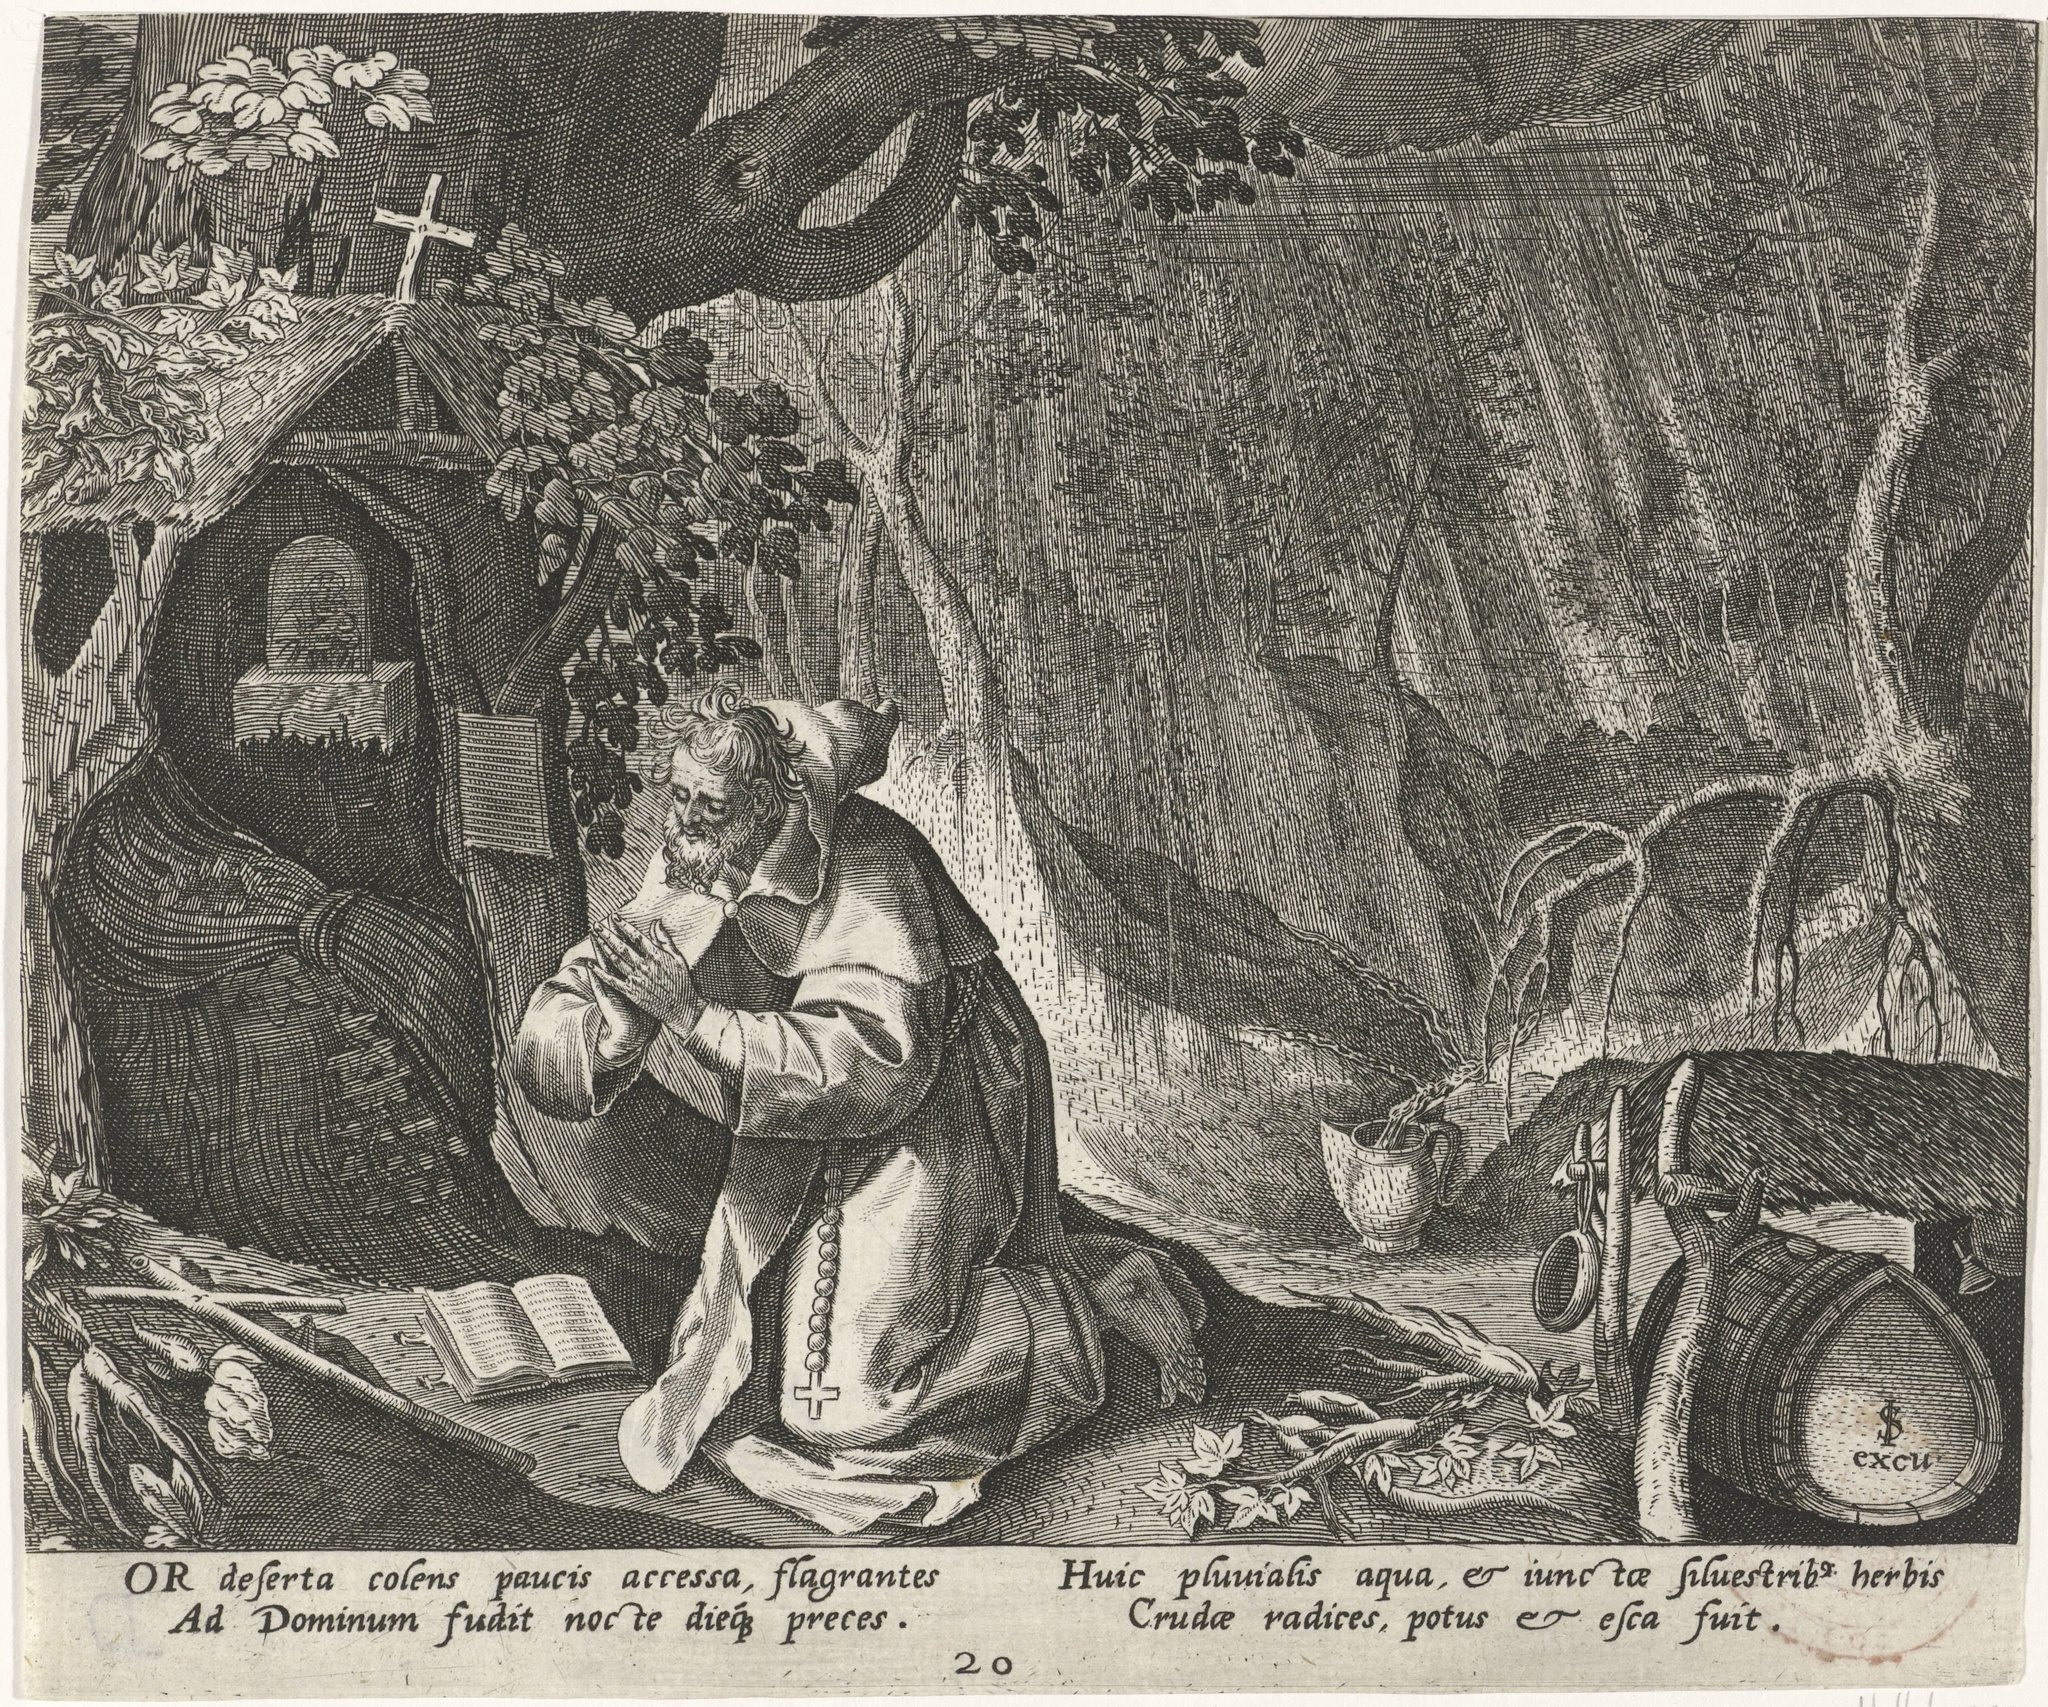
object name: print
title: Solitudo Sive Vitae Patrum Eremicolarum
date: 1586-1588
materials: paper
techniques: engraving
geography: antwerp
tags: saints, anchorite, hermit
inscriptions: collector's mark: Lugt 240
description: Or de kluizenaar in de wildernis. Het regent. Or zit geknield voor een bijbel en een crucifix. Rechts een hutje met een Maria-icoon.